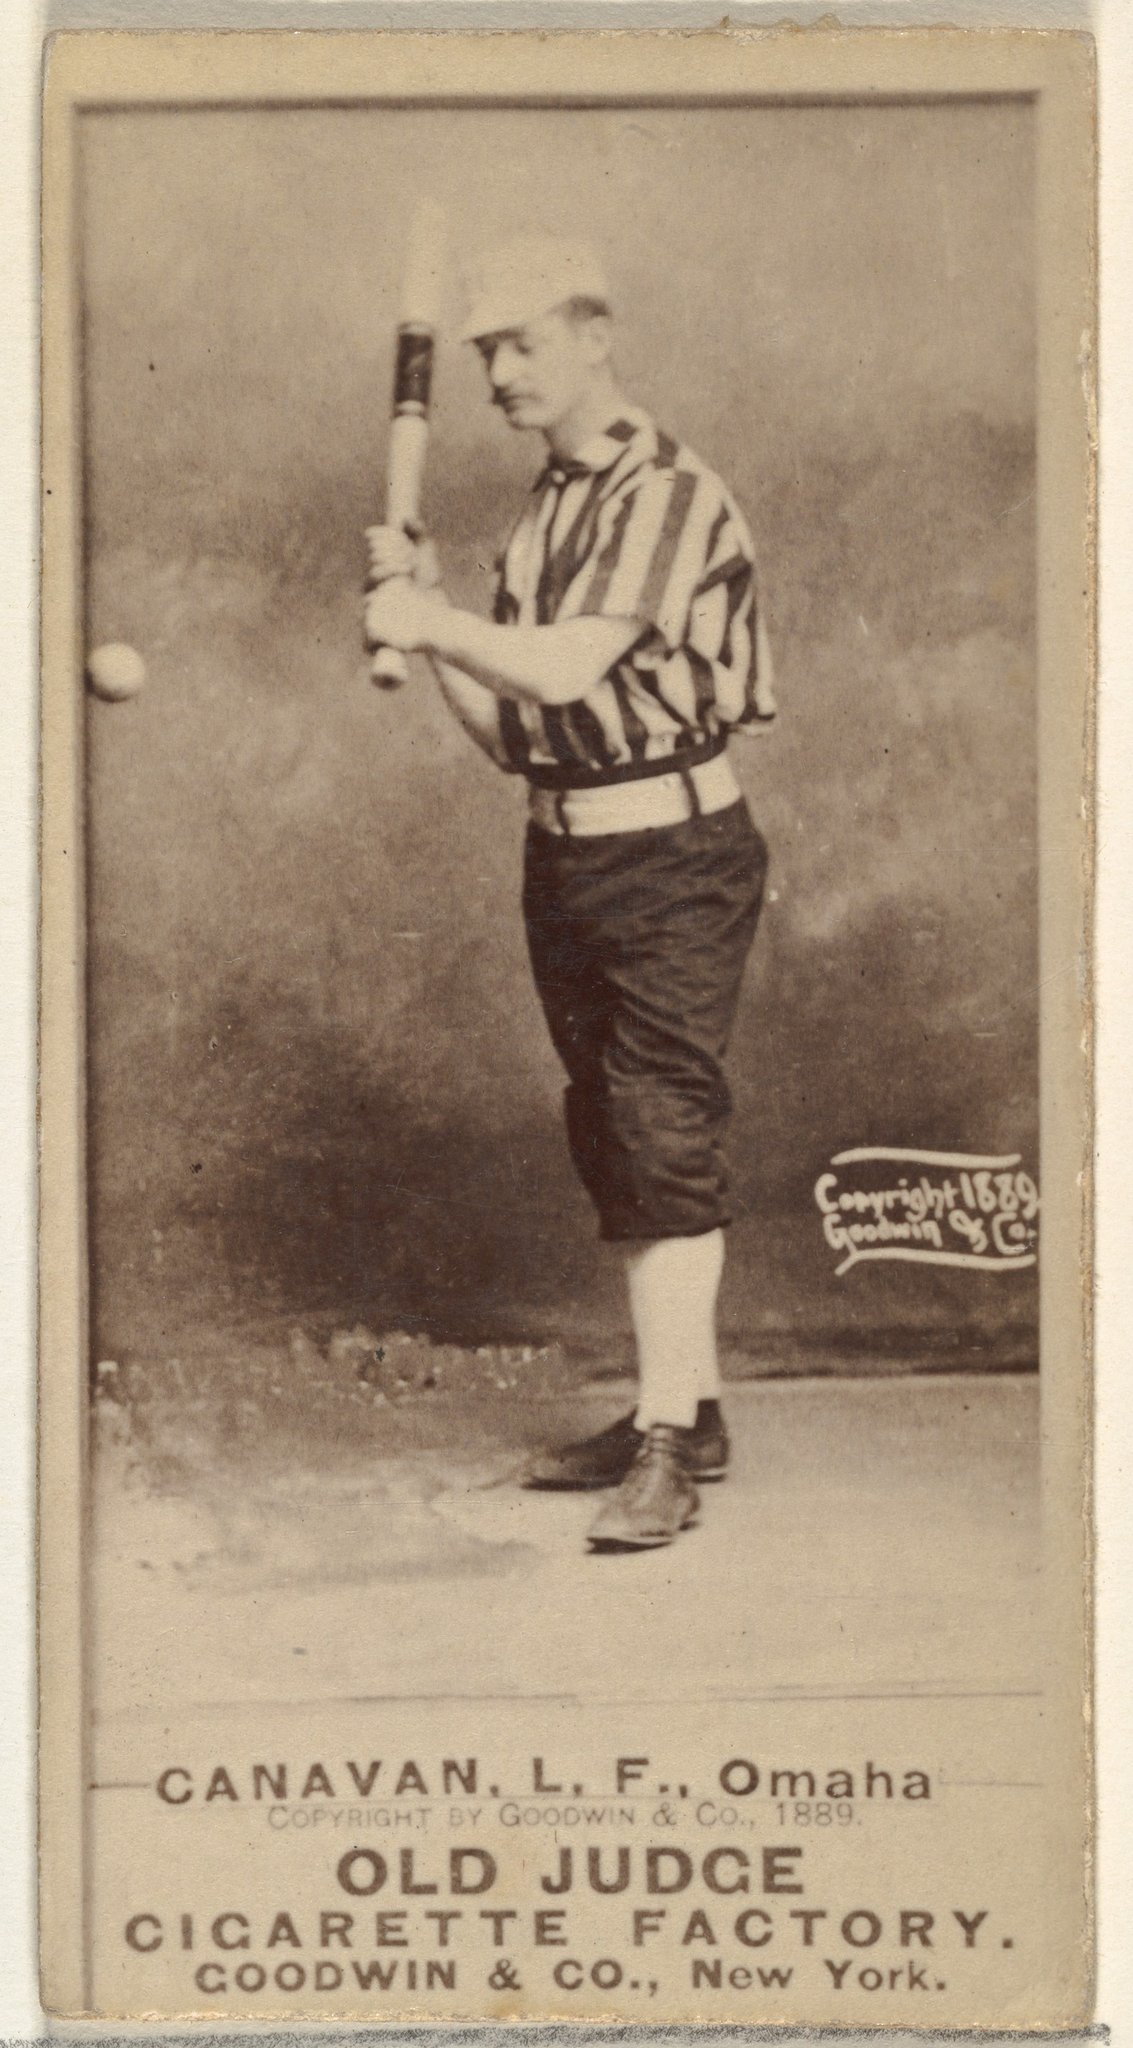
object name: baseball card, photograph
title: James Edward "Jim" Canavan, Left Field, Omaha Omahogs/ Lambs, from the Old Judge series (N172) for Old Judge Cigarettes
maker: goodwin & company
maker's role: publisher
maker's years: 1850-1950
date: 1889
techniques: albumen silver print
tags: men,portraits,baseball,athletes